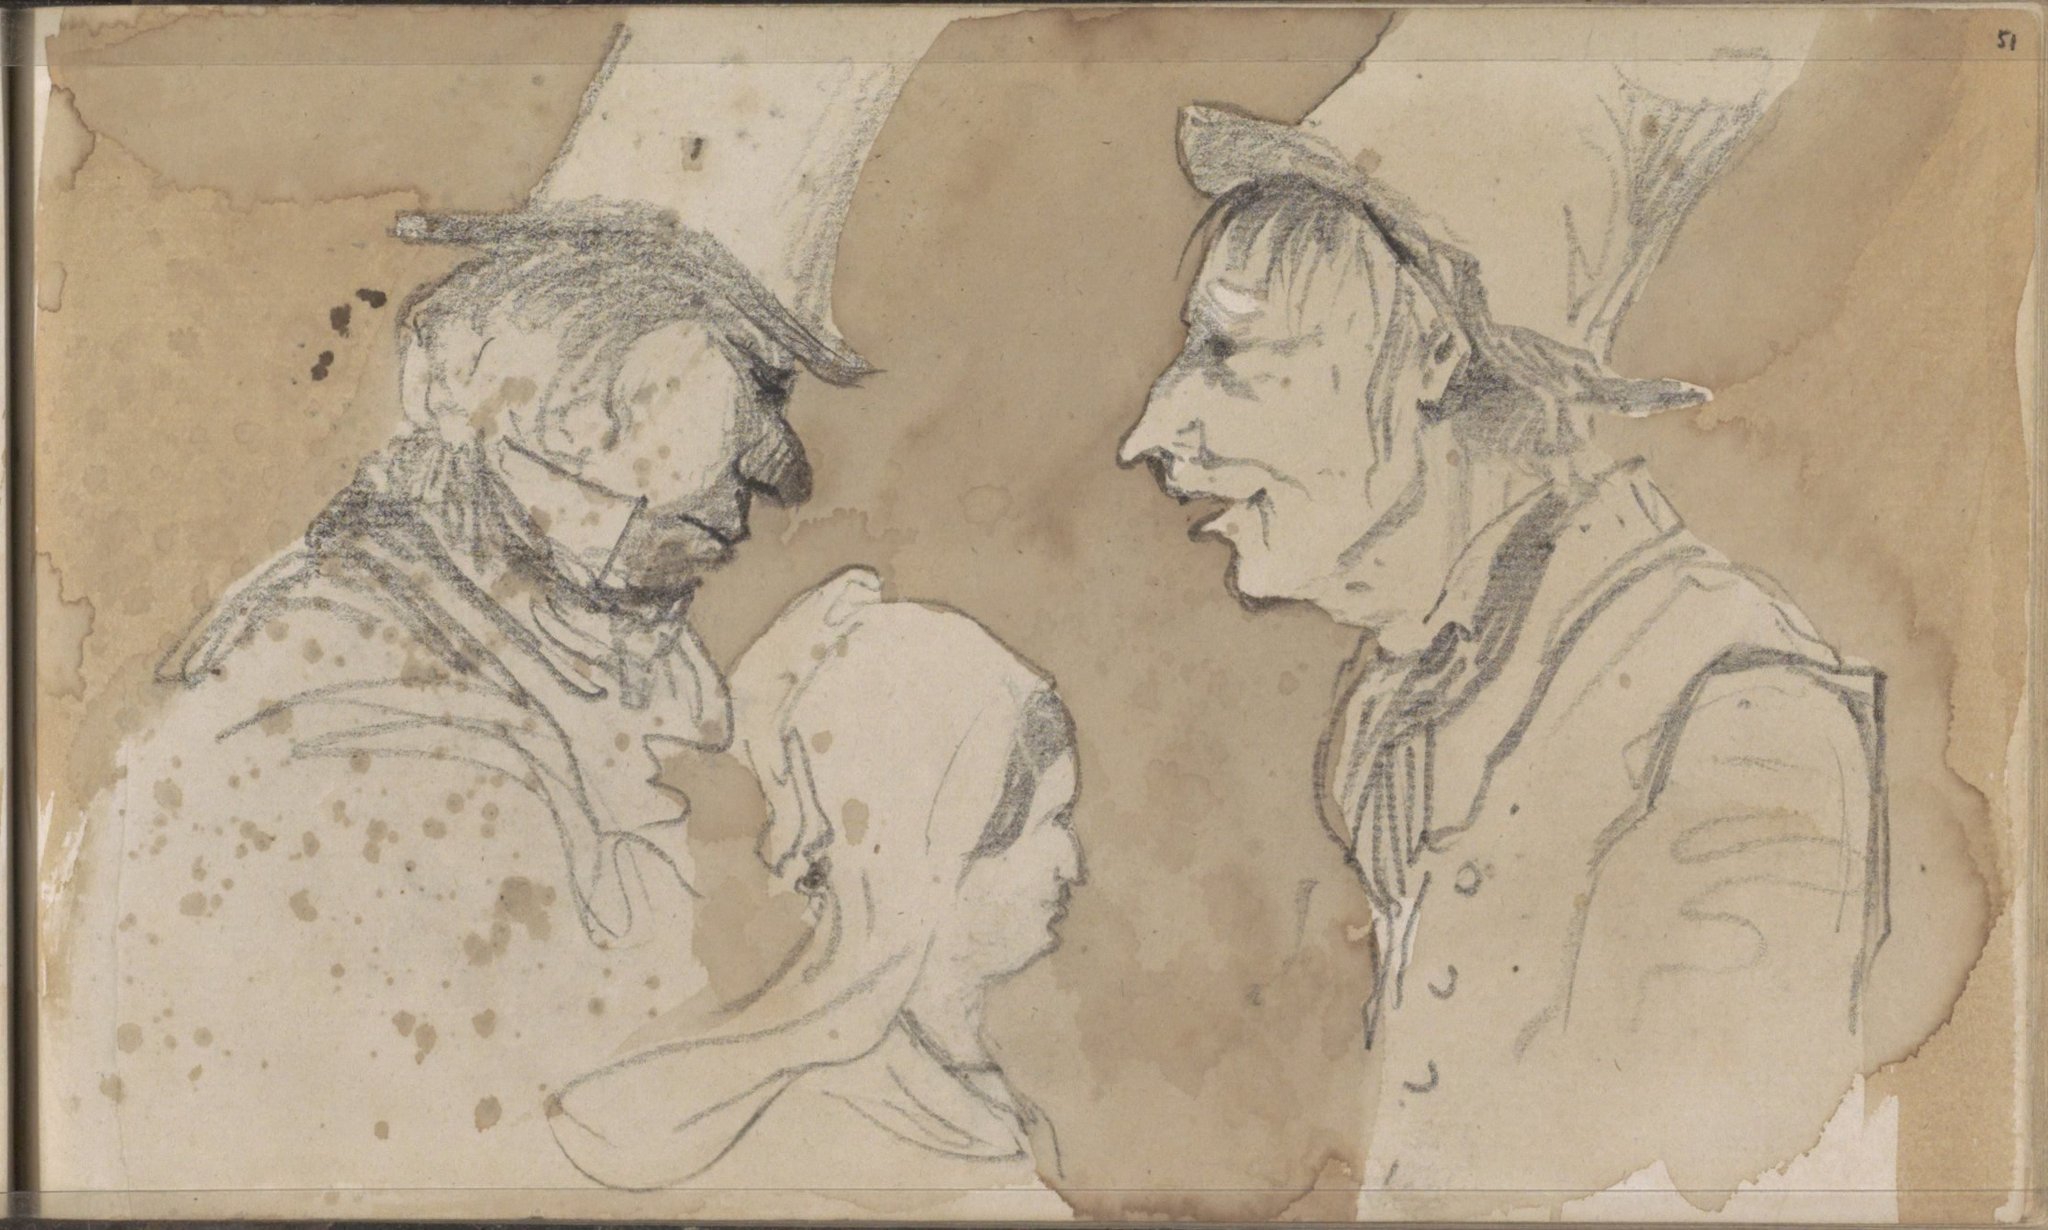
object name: sketchbook leaf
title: Twee mannen met hoge hoeden en een vrouw met een kap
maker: johannes tavenraat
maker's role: draughtsman, painter, print maker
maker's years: 1809-1881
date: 1864-1880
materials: ink, paper, pencil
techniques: brush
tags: head (human), adult woman, adult man, head-gear: cap (+ women's clothes)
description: Blad 51 recto uit een schetsboek met 98 bladen.